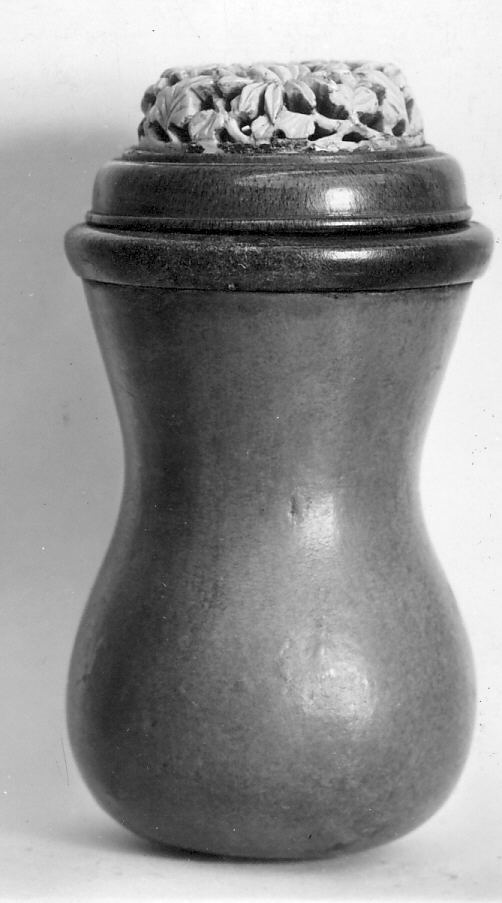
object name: cricket cage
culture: chinese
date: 1701-1900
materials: ivory